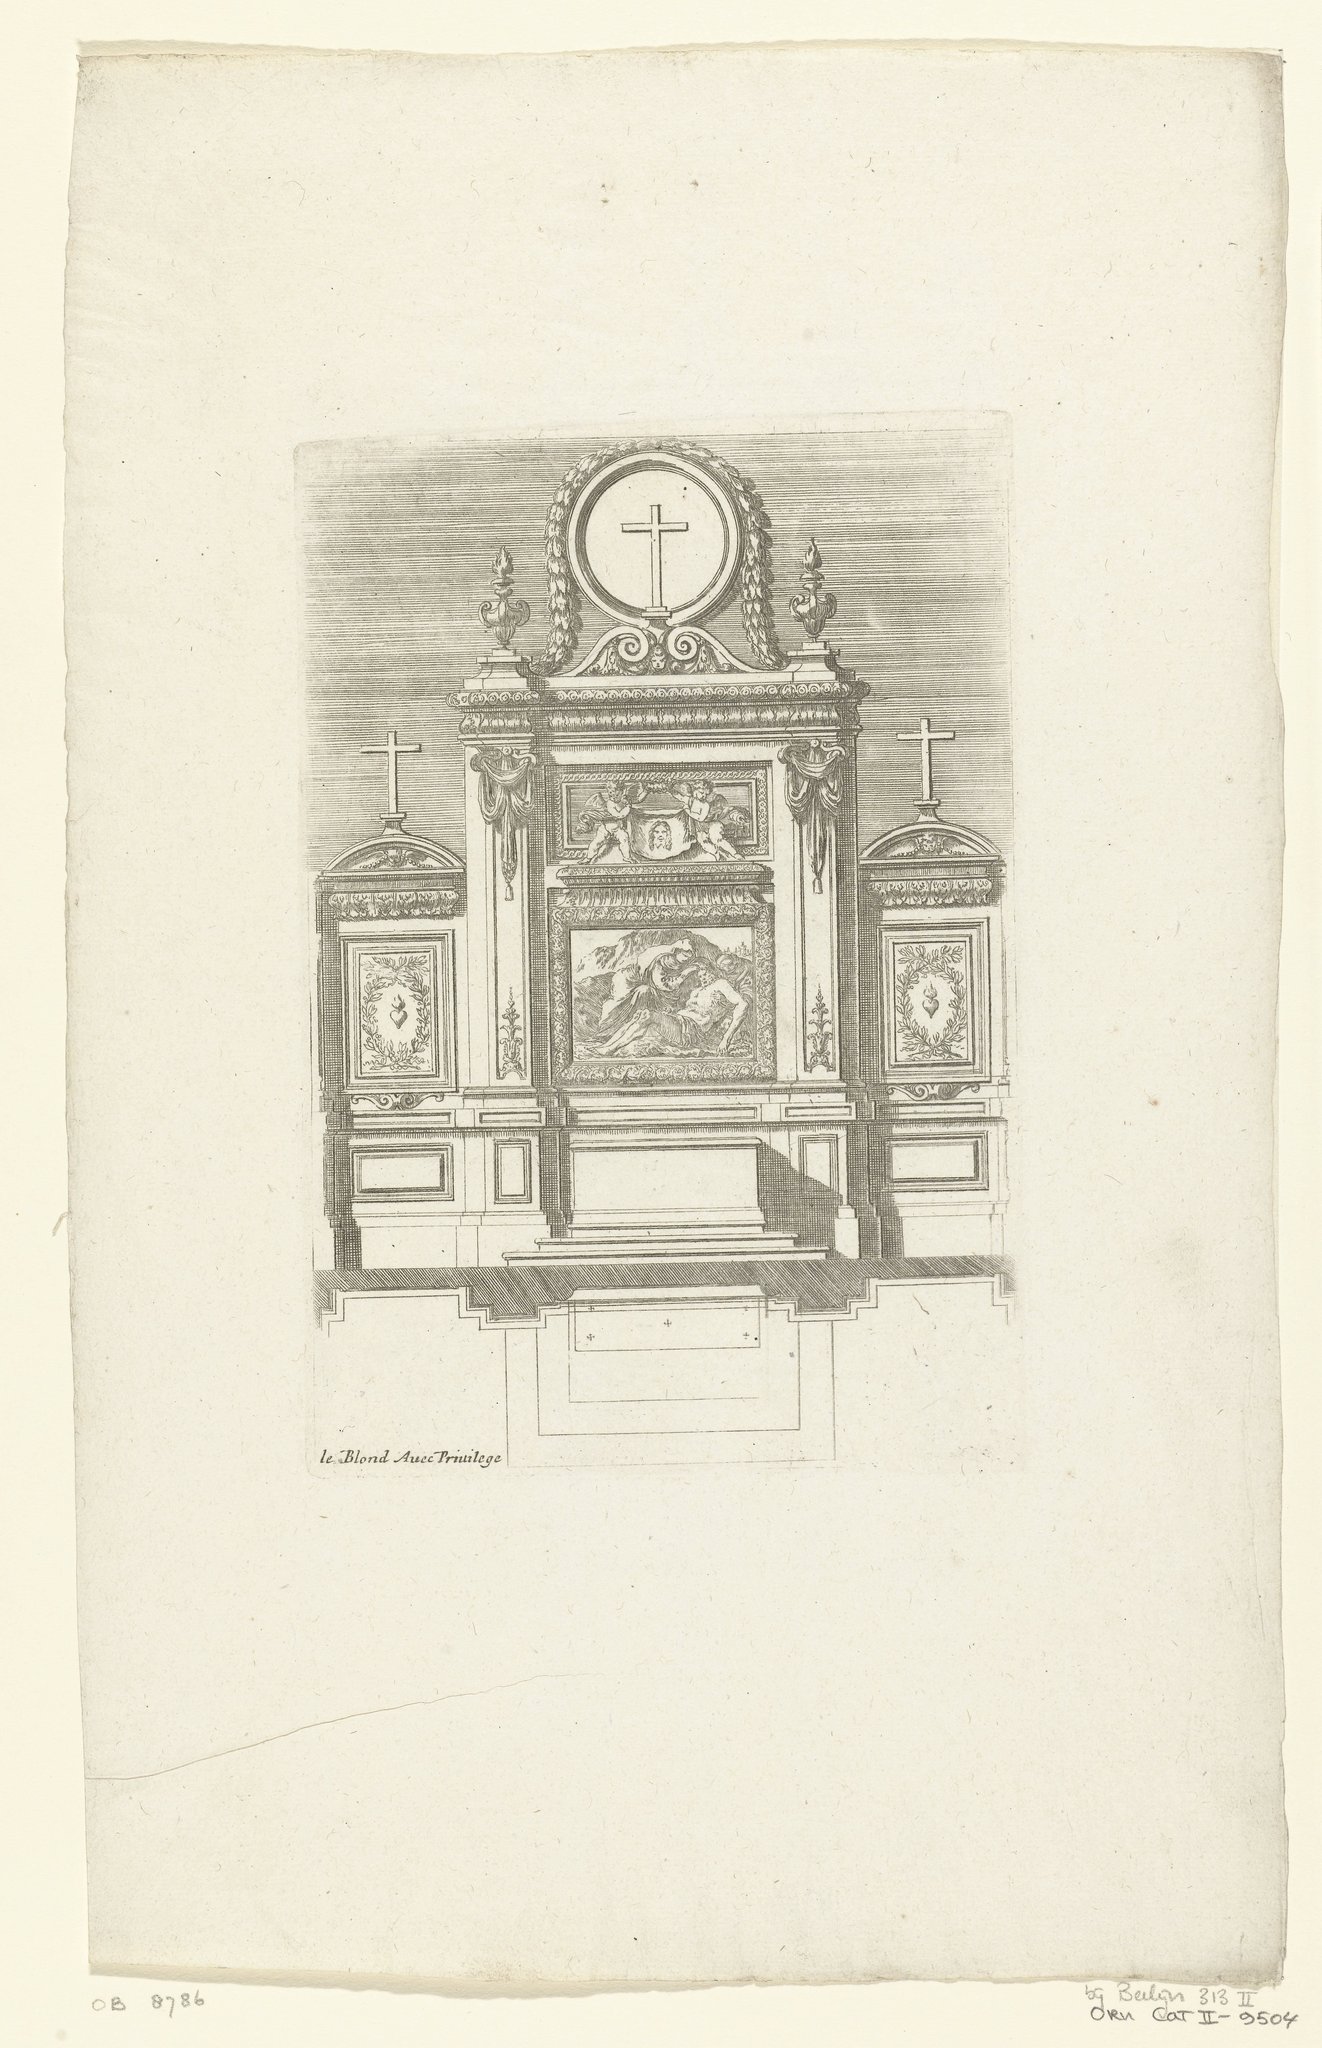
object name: ornament print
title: Altaar met schilderij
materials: paper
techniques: etching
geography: france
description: In het midden hangt een schilderij met een detail van de Kruisafneming. Met opstand en plan. Uit serie van 6 bladen, eerste editie.